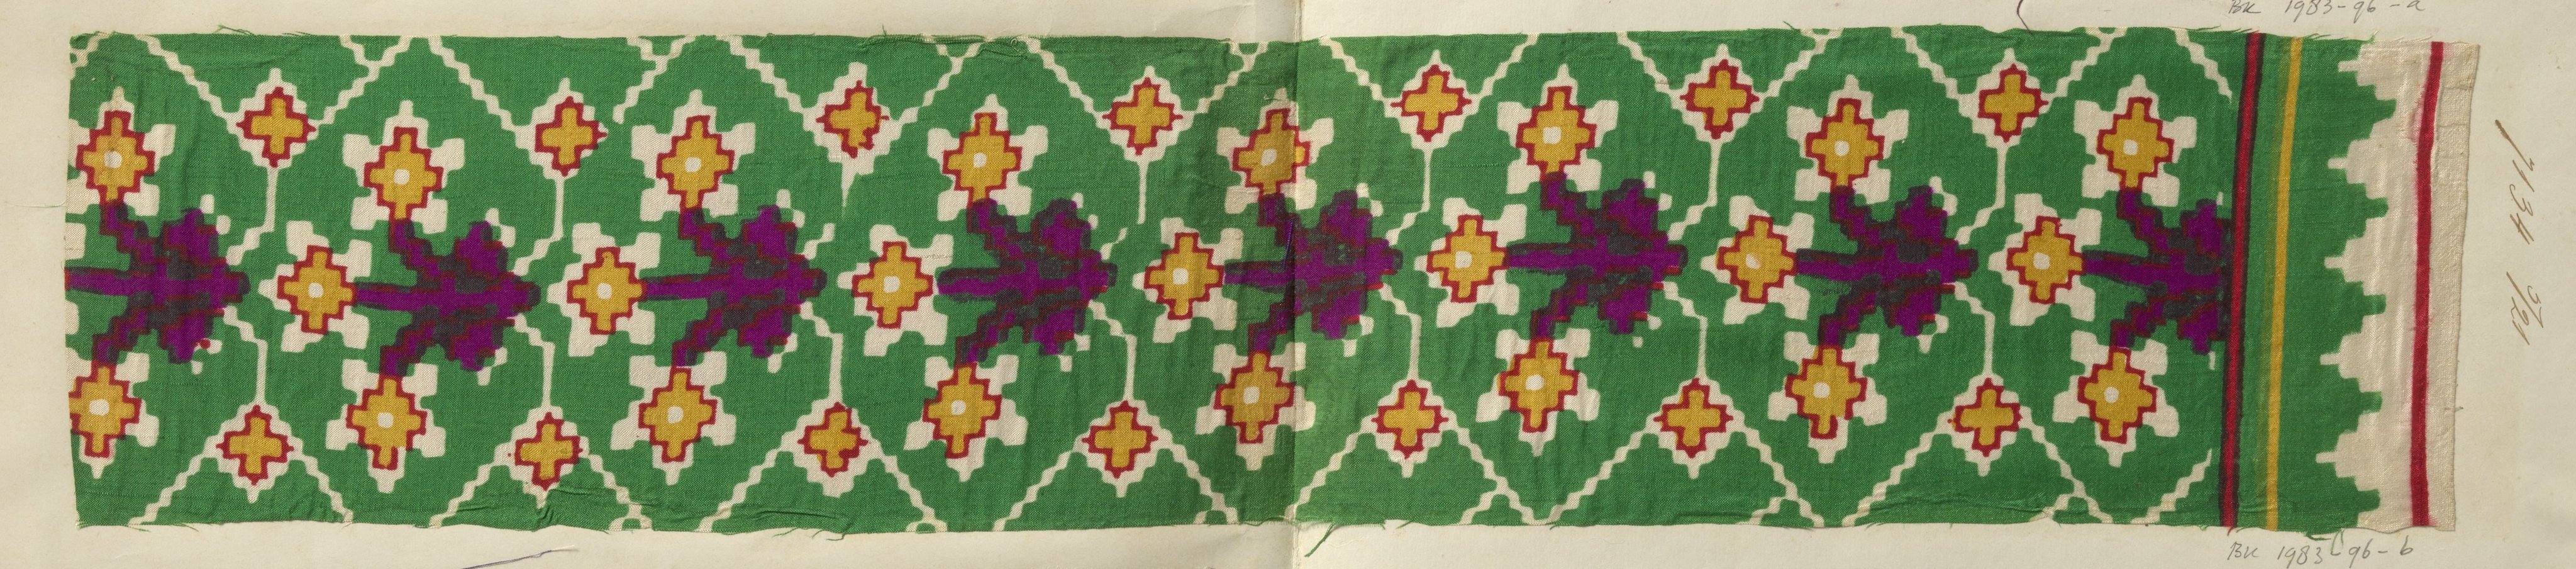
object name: sample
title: Staal zijde in album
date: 1910-1932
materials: silk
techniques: printing block, weave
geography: vienna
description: Staal bedrukte zijde, groen, rood, geel en paars op naturel, met gestileerde bloemplant binnen paralellepipedum-vormige omlijsting (dessinnr. 7134 5/21).